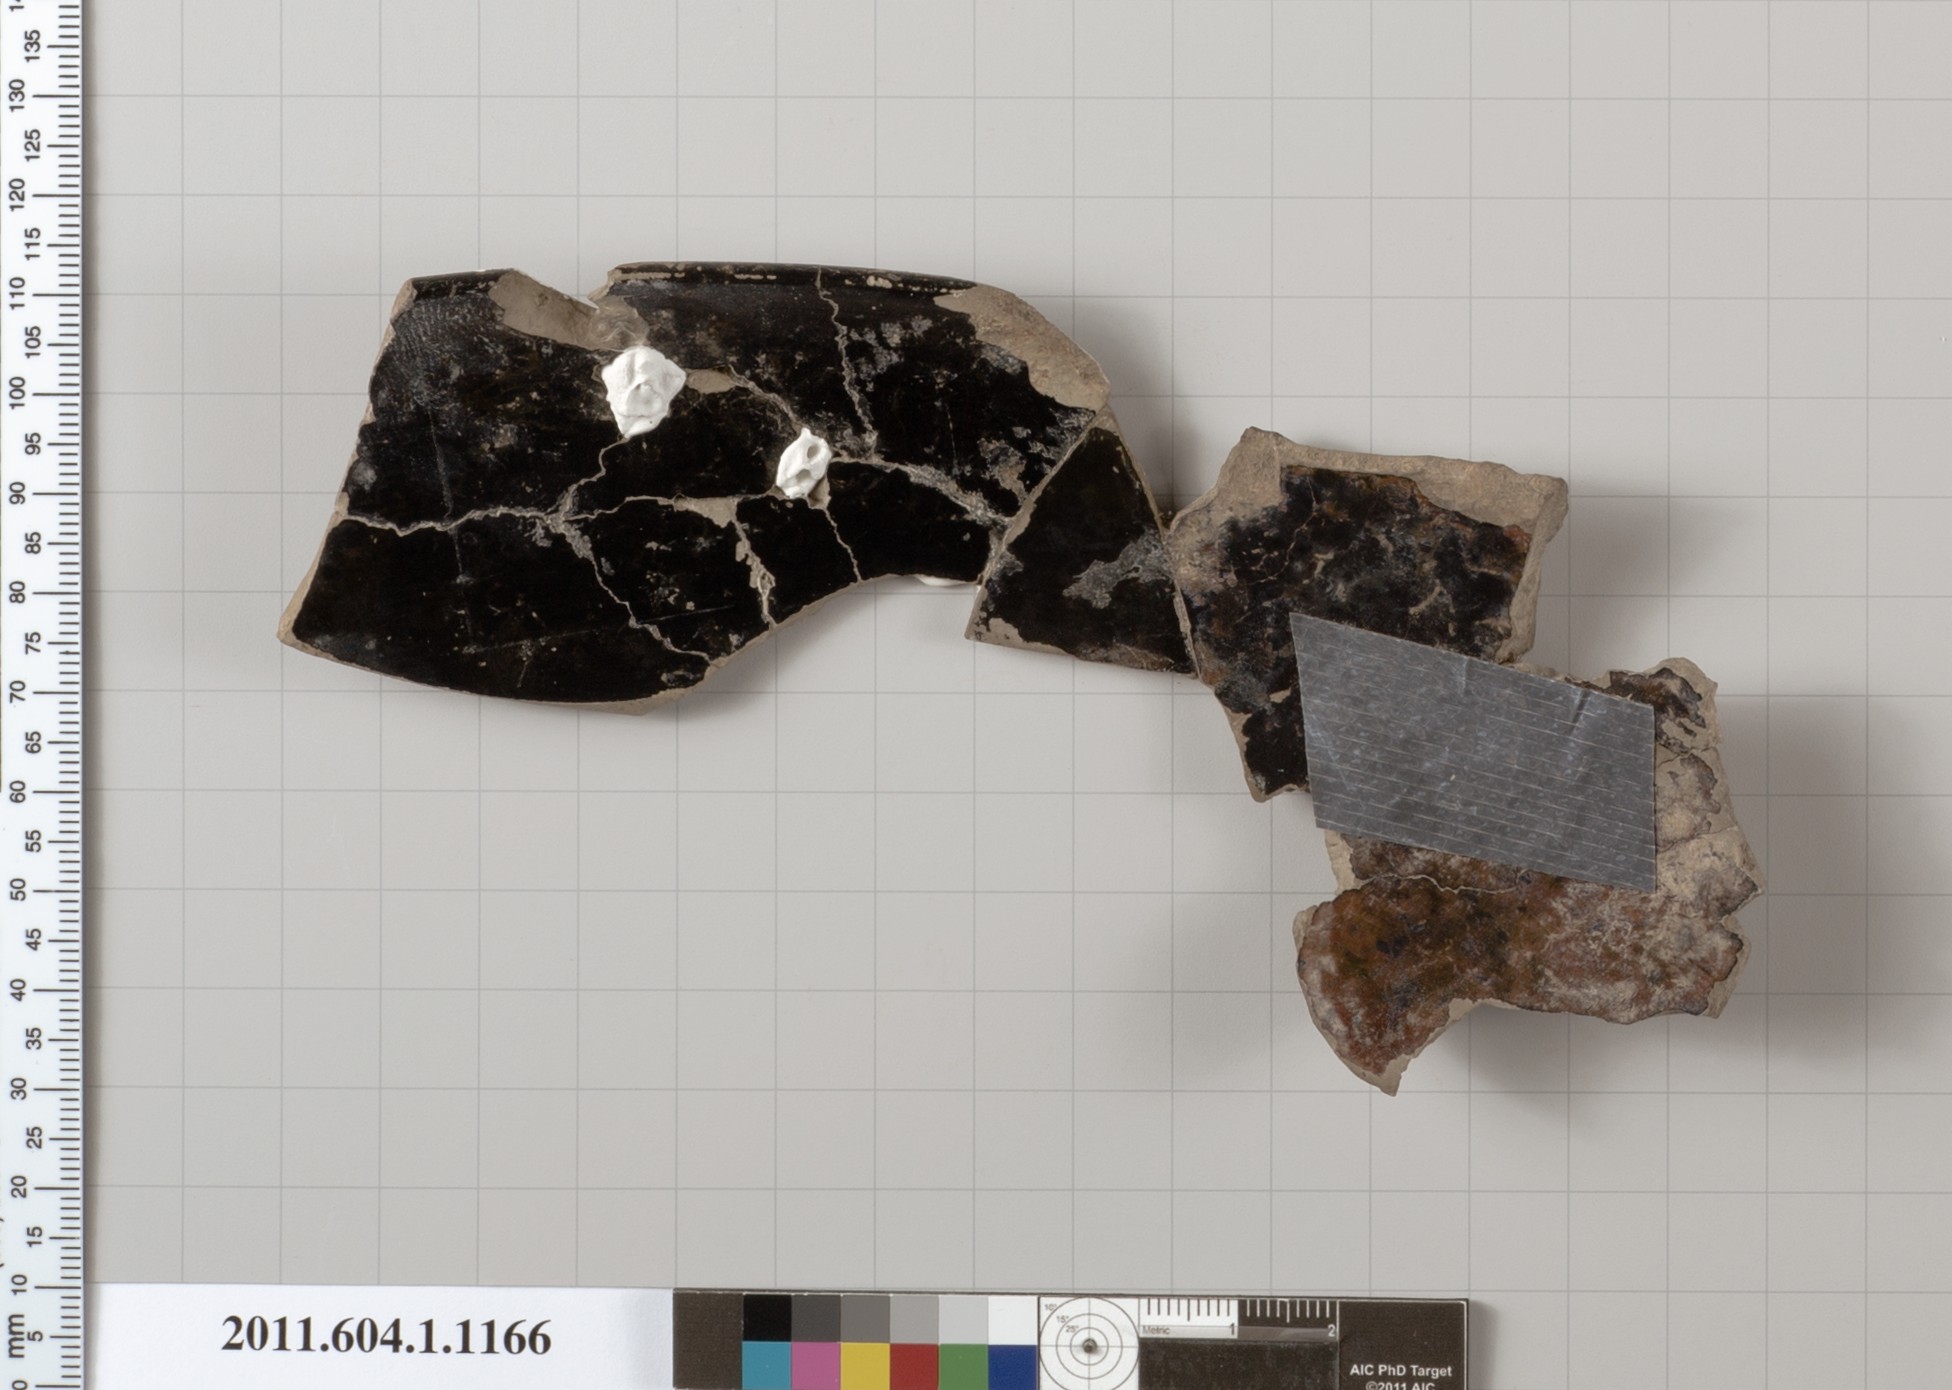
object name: kylix fragment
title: Terracotta fragment of a kylix (drinking cup)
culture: greek, attic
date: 490-480 BCE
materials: terracotta